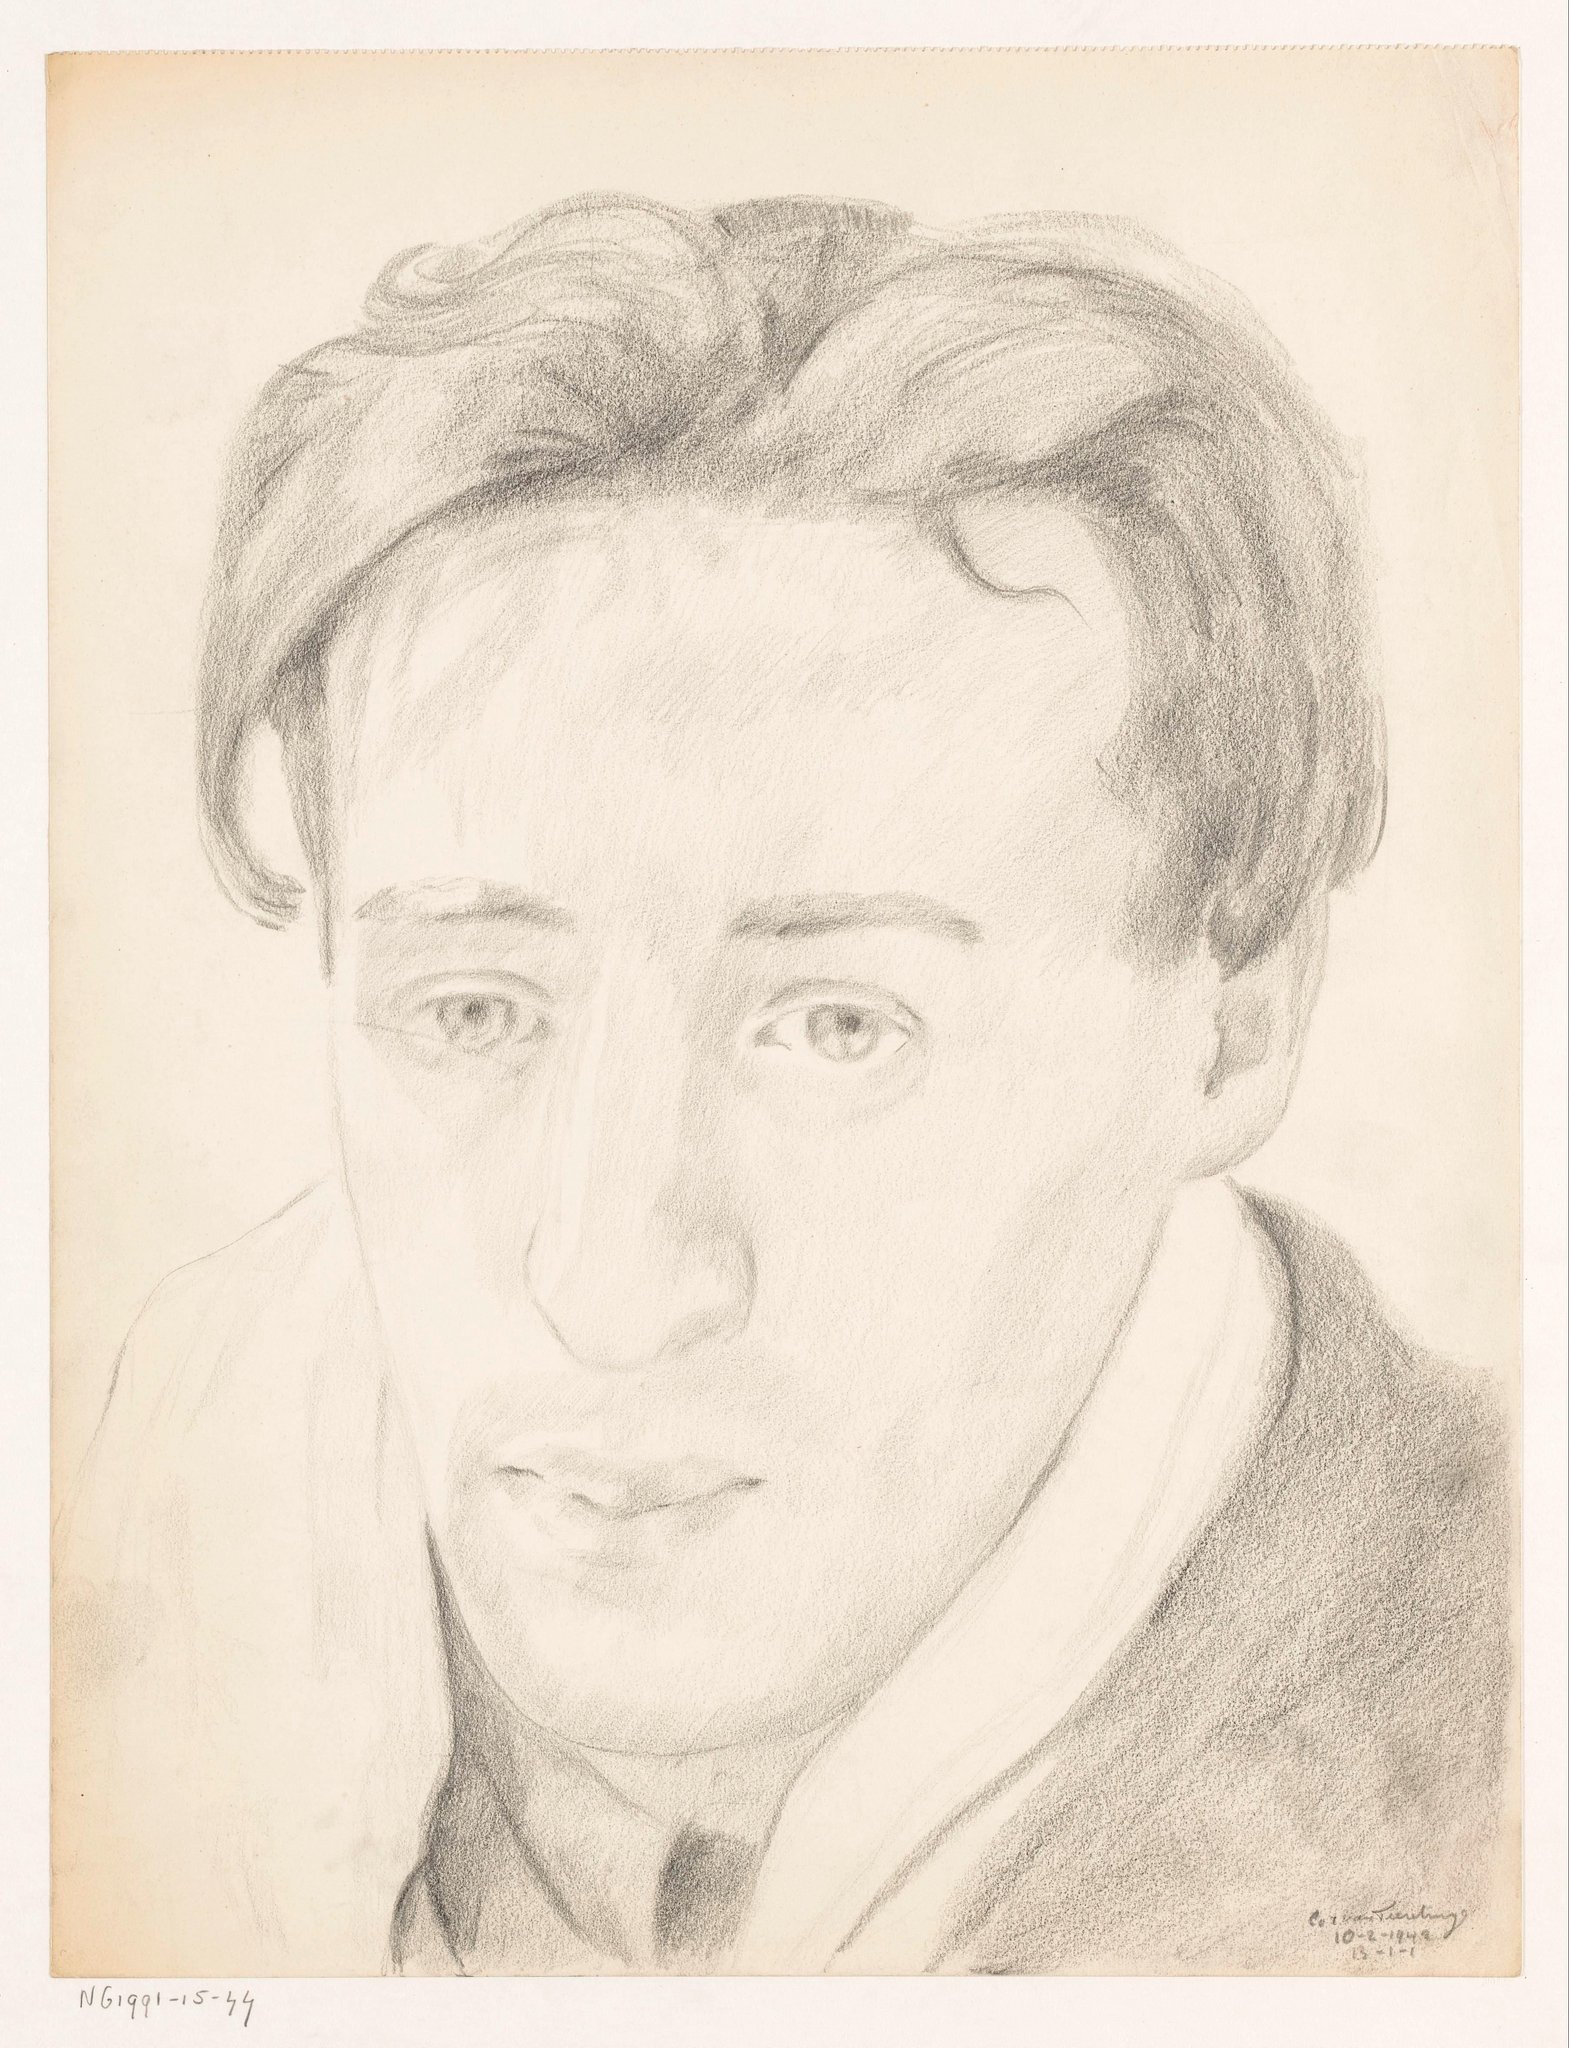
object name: drawing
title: Zelfportretten van Cor van Teeseling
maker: cor van teeseling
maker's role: draughtsman, sculptor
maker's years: 1915-1942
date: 1942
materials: paper, pencil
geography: weteringschans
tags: amsterdam, draughtsman, sculptor, cor van teeseling, historical persons, prisoner in cell or locked place, portrait, self-portrait of draughtsman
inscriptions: signature and date: ‘Cor van Teeseling / 10-2-1942 / B-1-1’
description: Zelfportret van Cor van Teeseling met sjaal: B-1-1, 10 februari. Getekend zelfportret van Cor van Teeseling driekwart met sjaal, zijn hoofd naar links gewend.